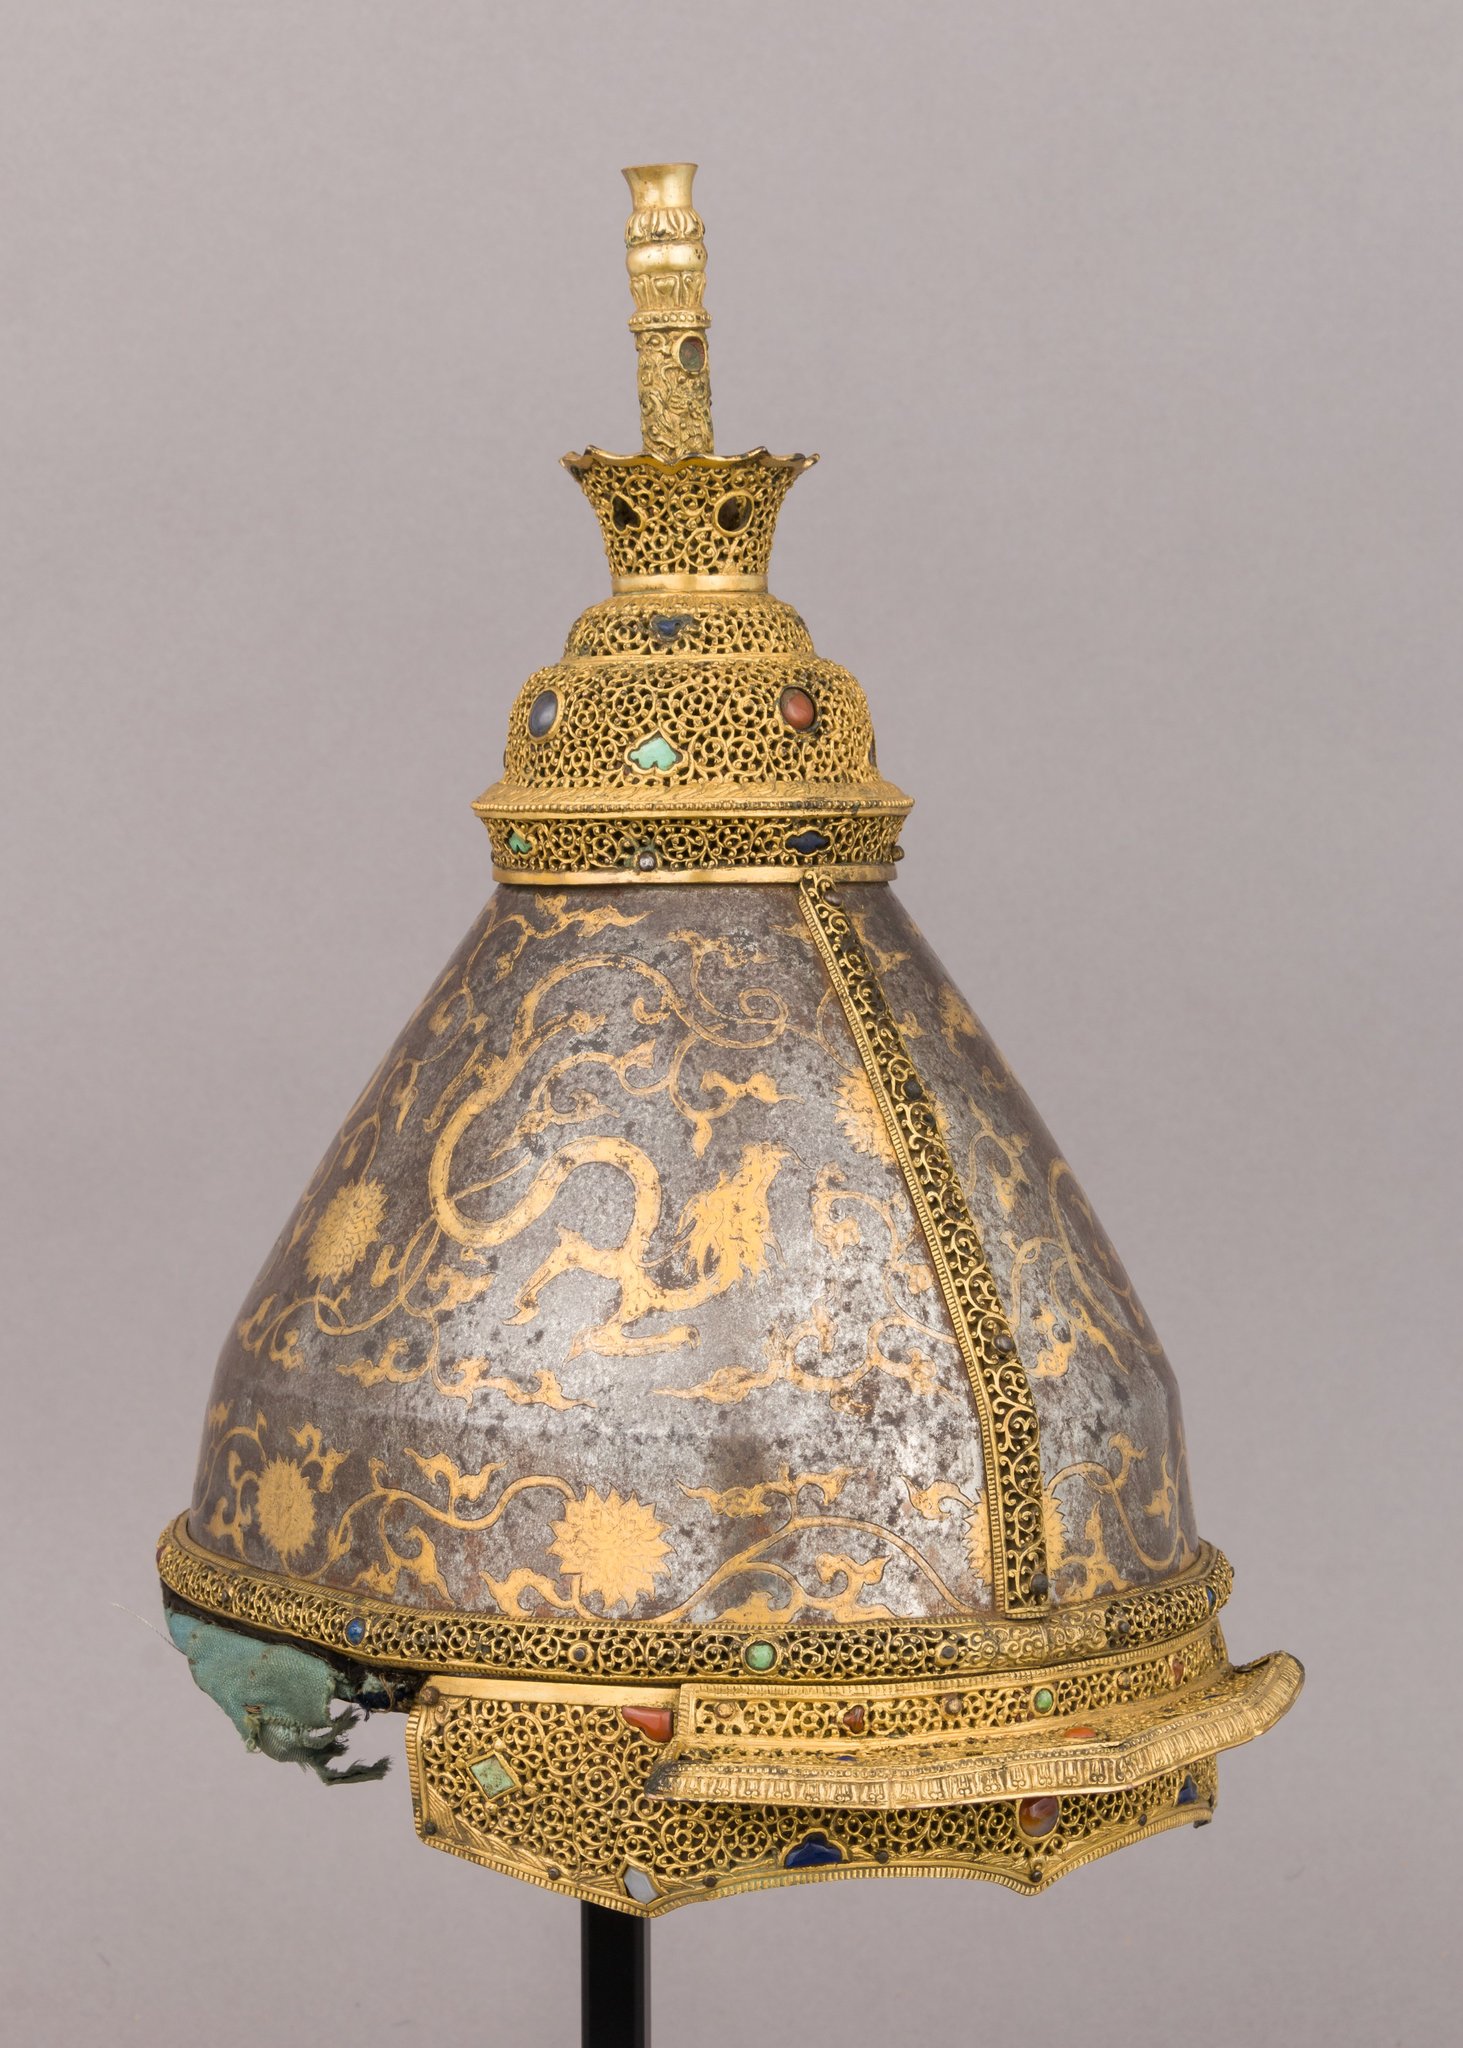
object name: armor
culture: chinese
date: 1701-1800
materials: gold, lacquer, steel, stone, textile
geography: china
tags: dragons